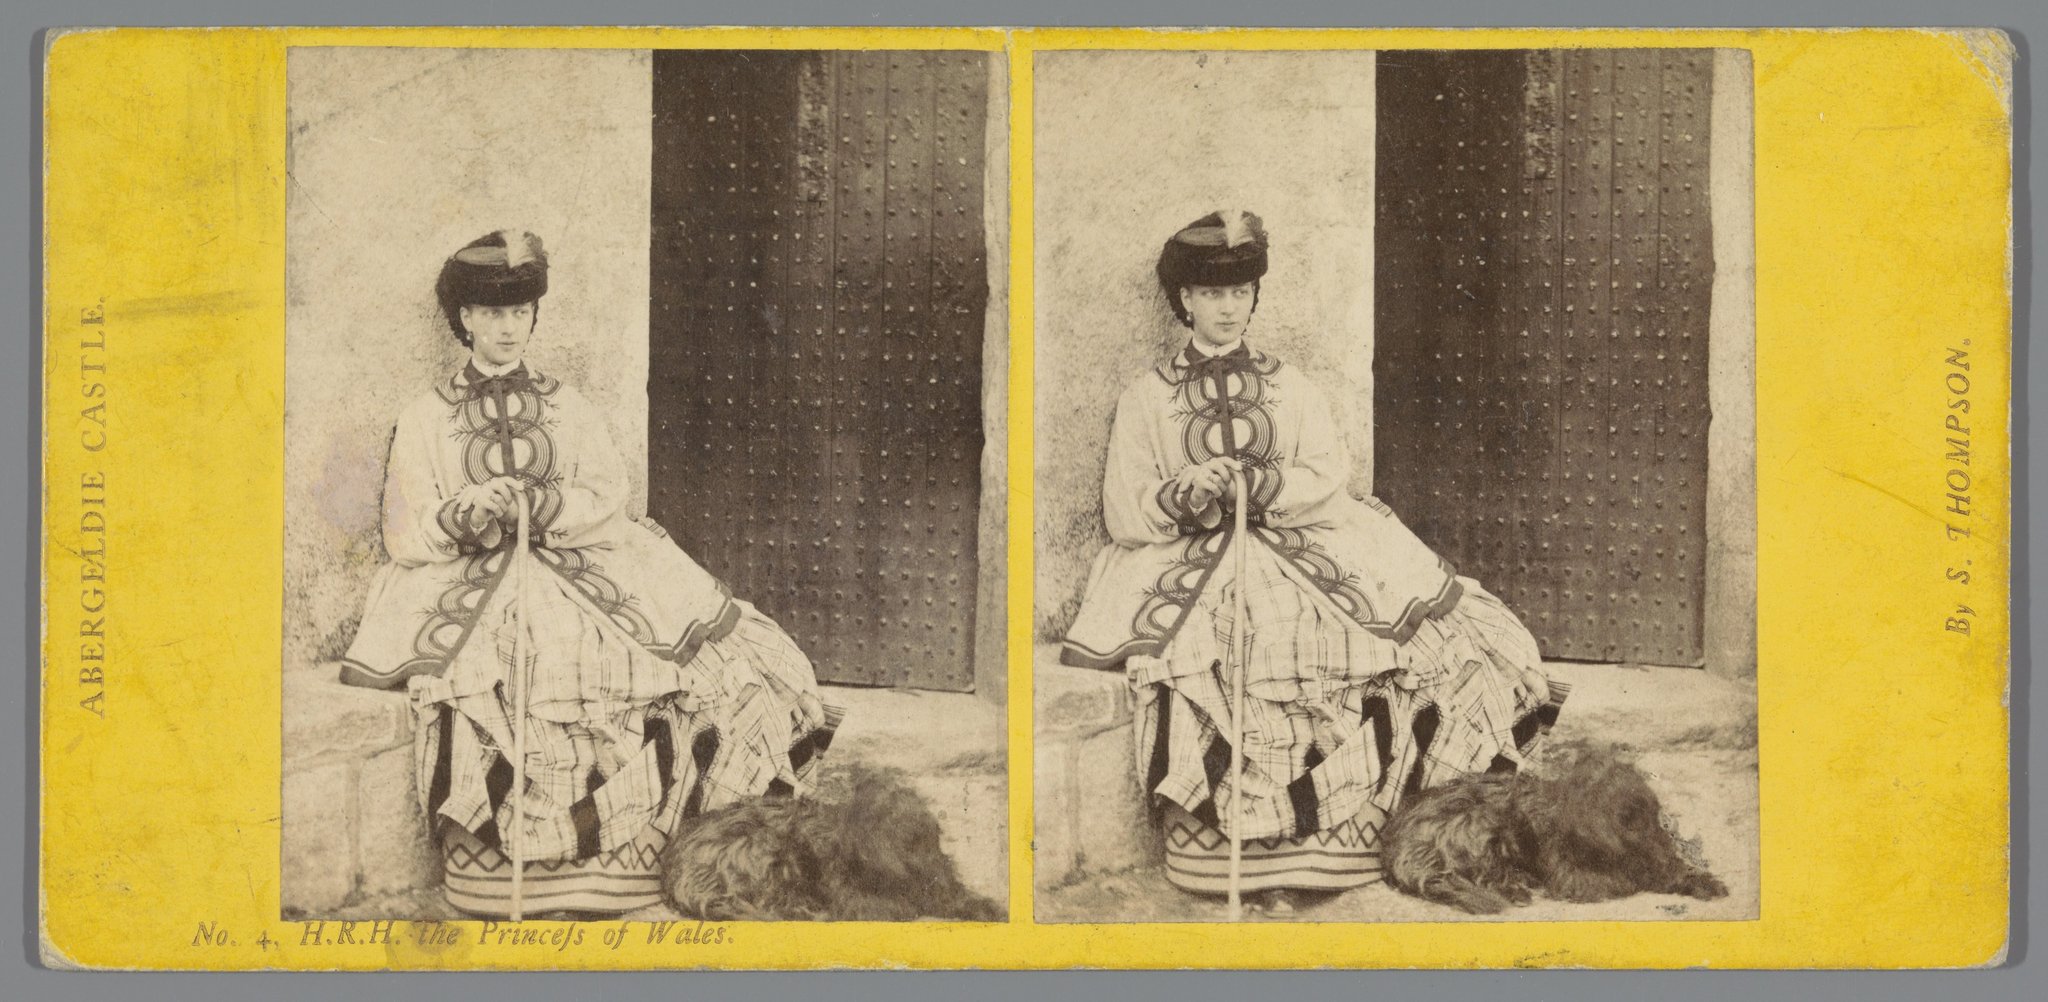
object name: stereograph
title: Portret van Alexandra van Denemarken, Princess of Wales met haar hond op Abergeldie Castle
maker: stephen thompson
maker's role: fotograaf, schrijver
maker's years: 1831-1893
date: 1865-1870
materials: cardboard, paper, photographic support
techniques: albumen print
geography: scotland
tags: historical persons - bb - woman, dog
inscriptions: title